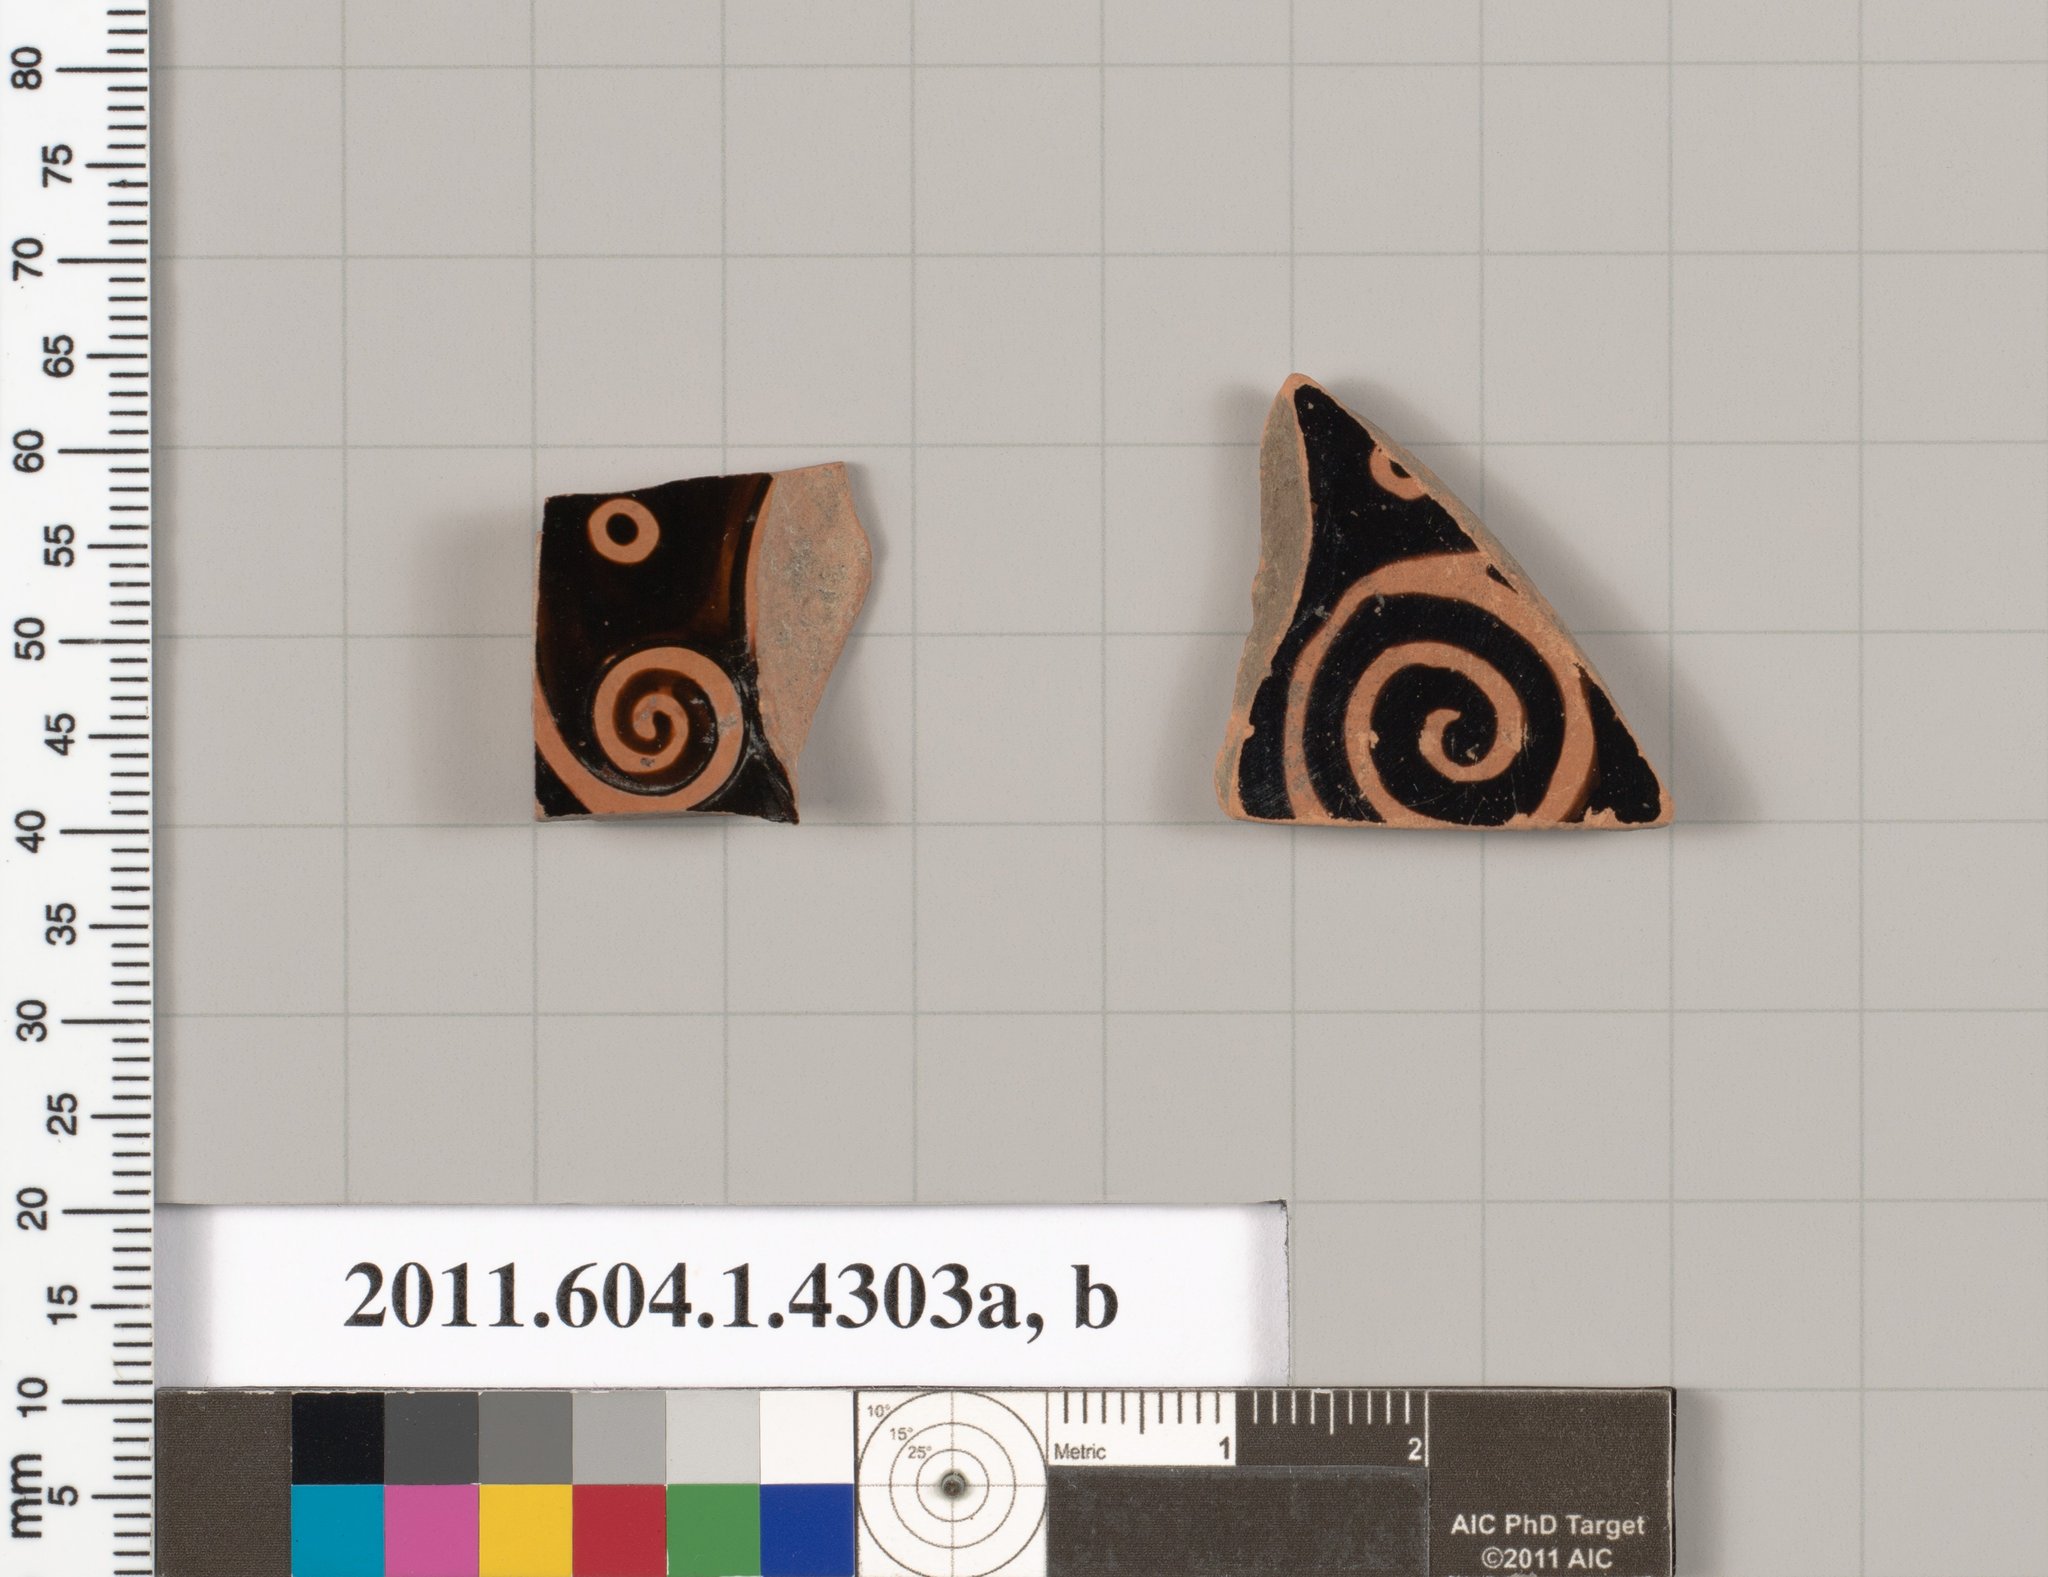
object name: kylix fragment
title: Terracotta fragments of kylikes (drinking cups)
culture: greek, attic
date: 500-451 BCE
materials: terracotta